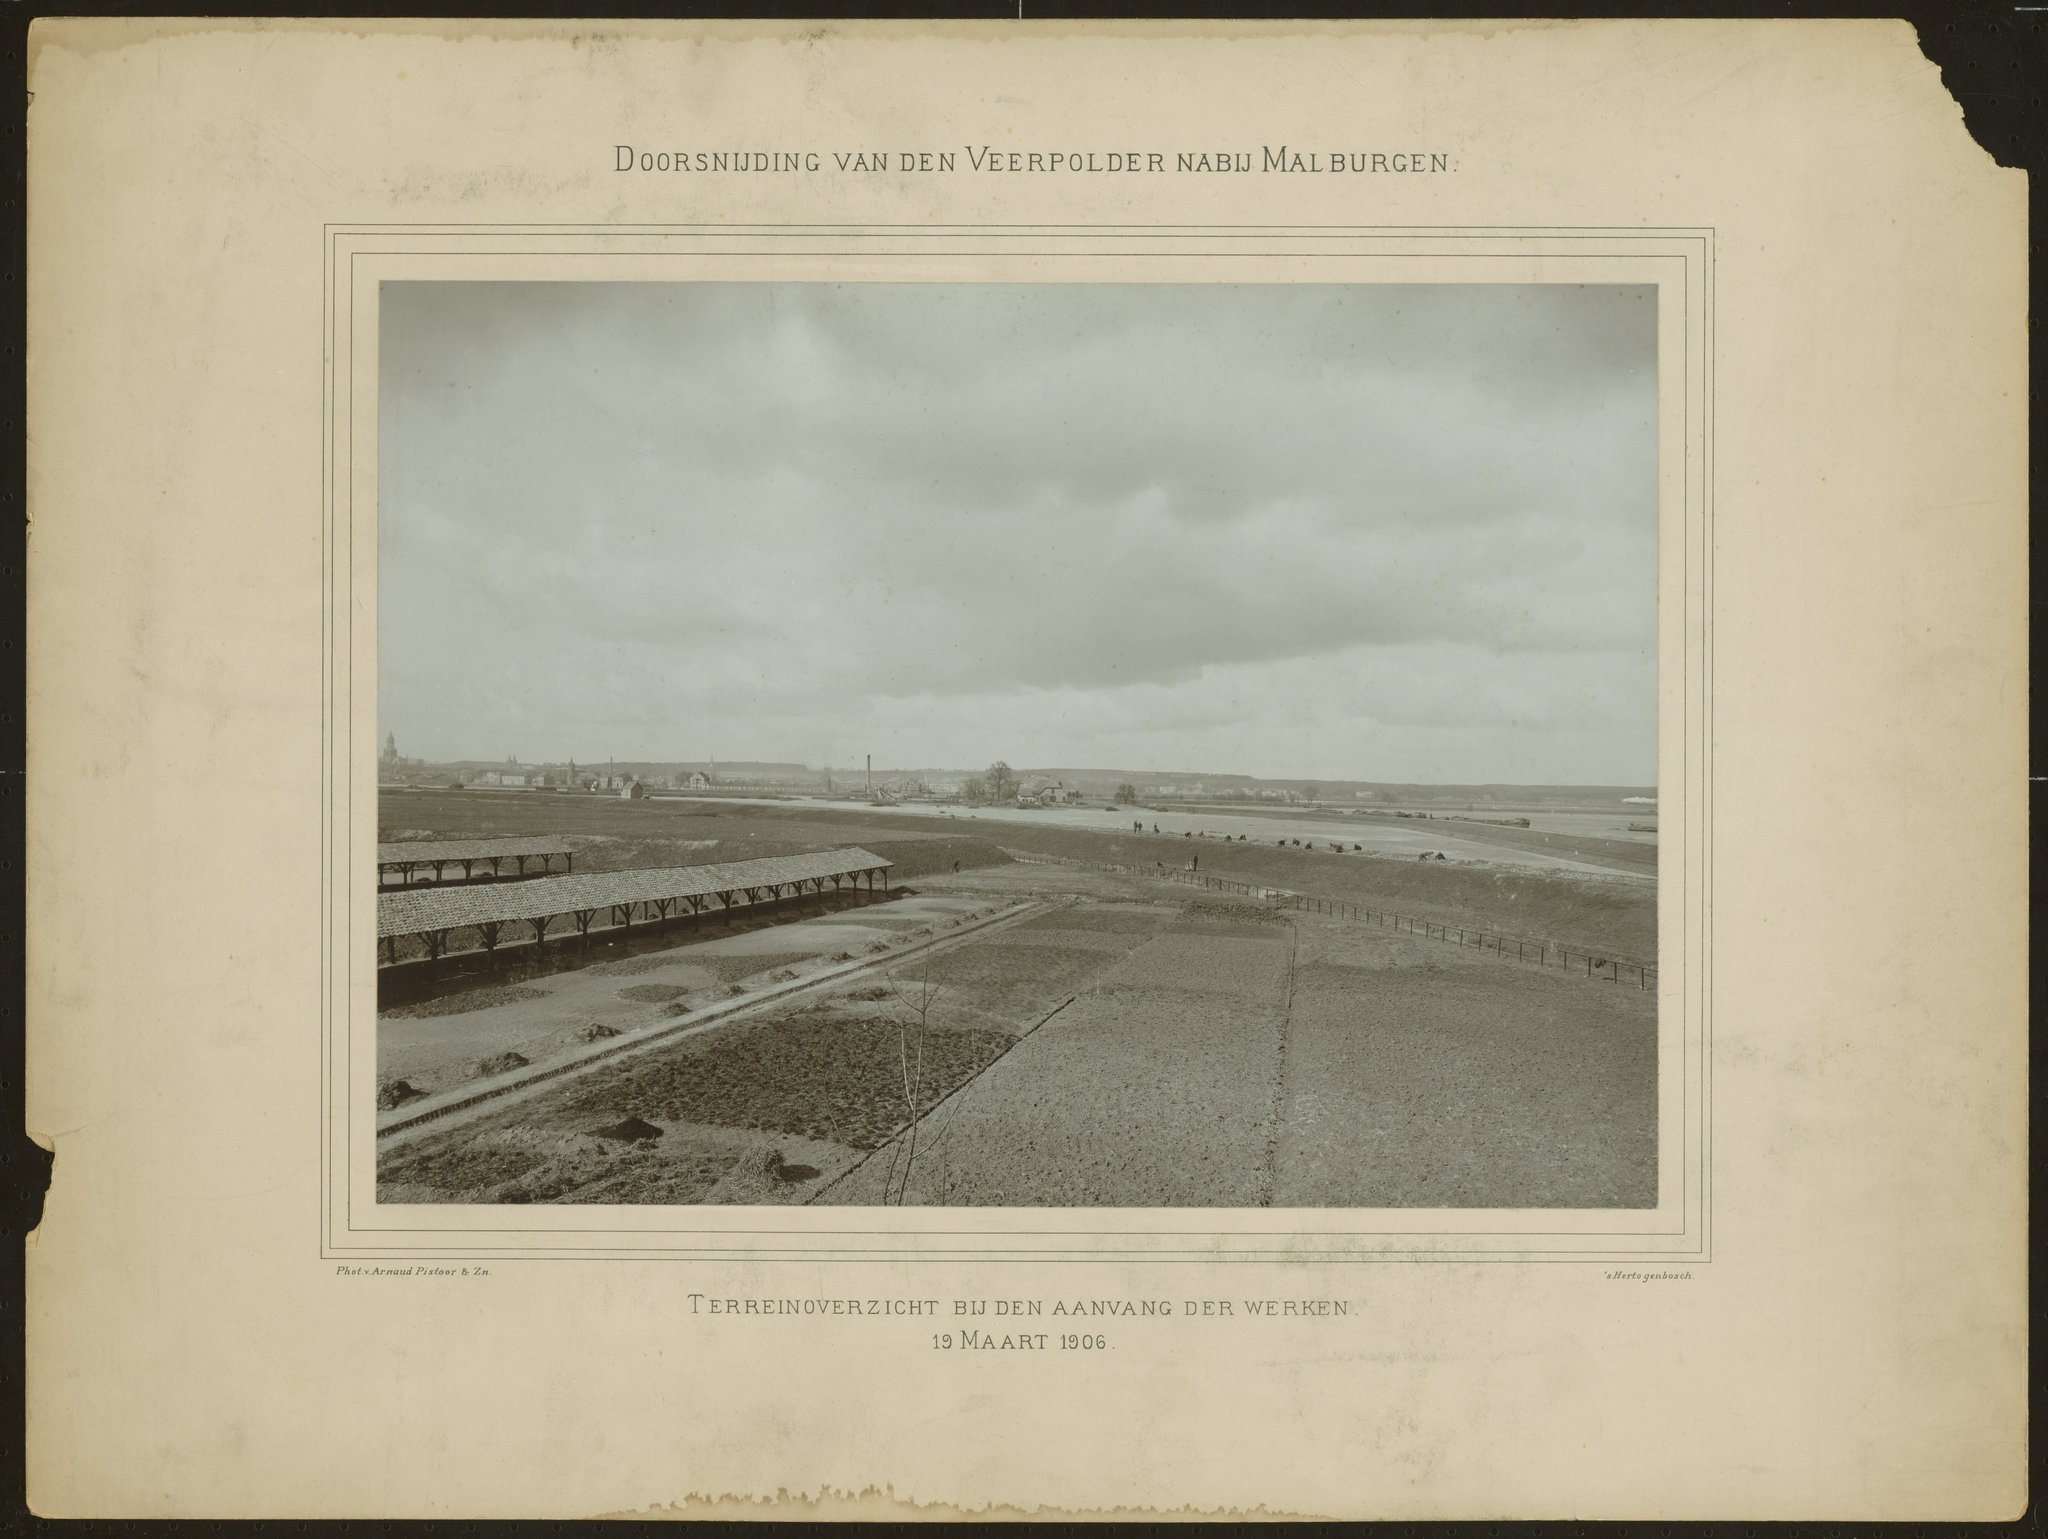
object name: photograph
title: Doorsnijding van den Veerpolder nabij Malburgen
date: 1906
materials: cardboard, paper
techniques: photography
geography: den bosch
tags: malburgen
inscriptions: date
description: Foto op karton. Opschrift: 'Terreinoverzicht bij den aanvang der werken, 19 maart 1906'. Gedateeerd en gesigneerd.